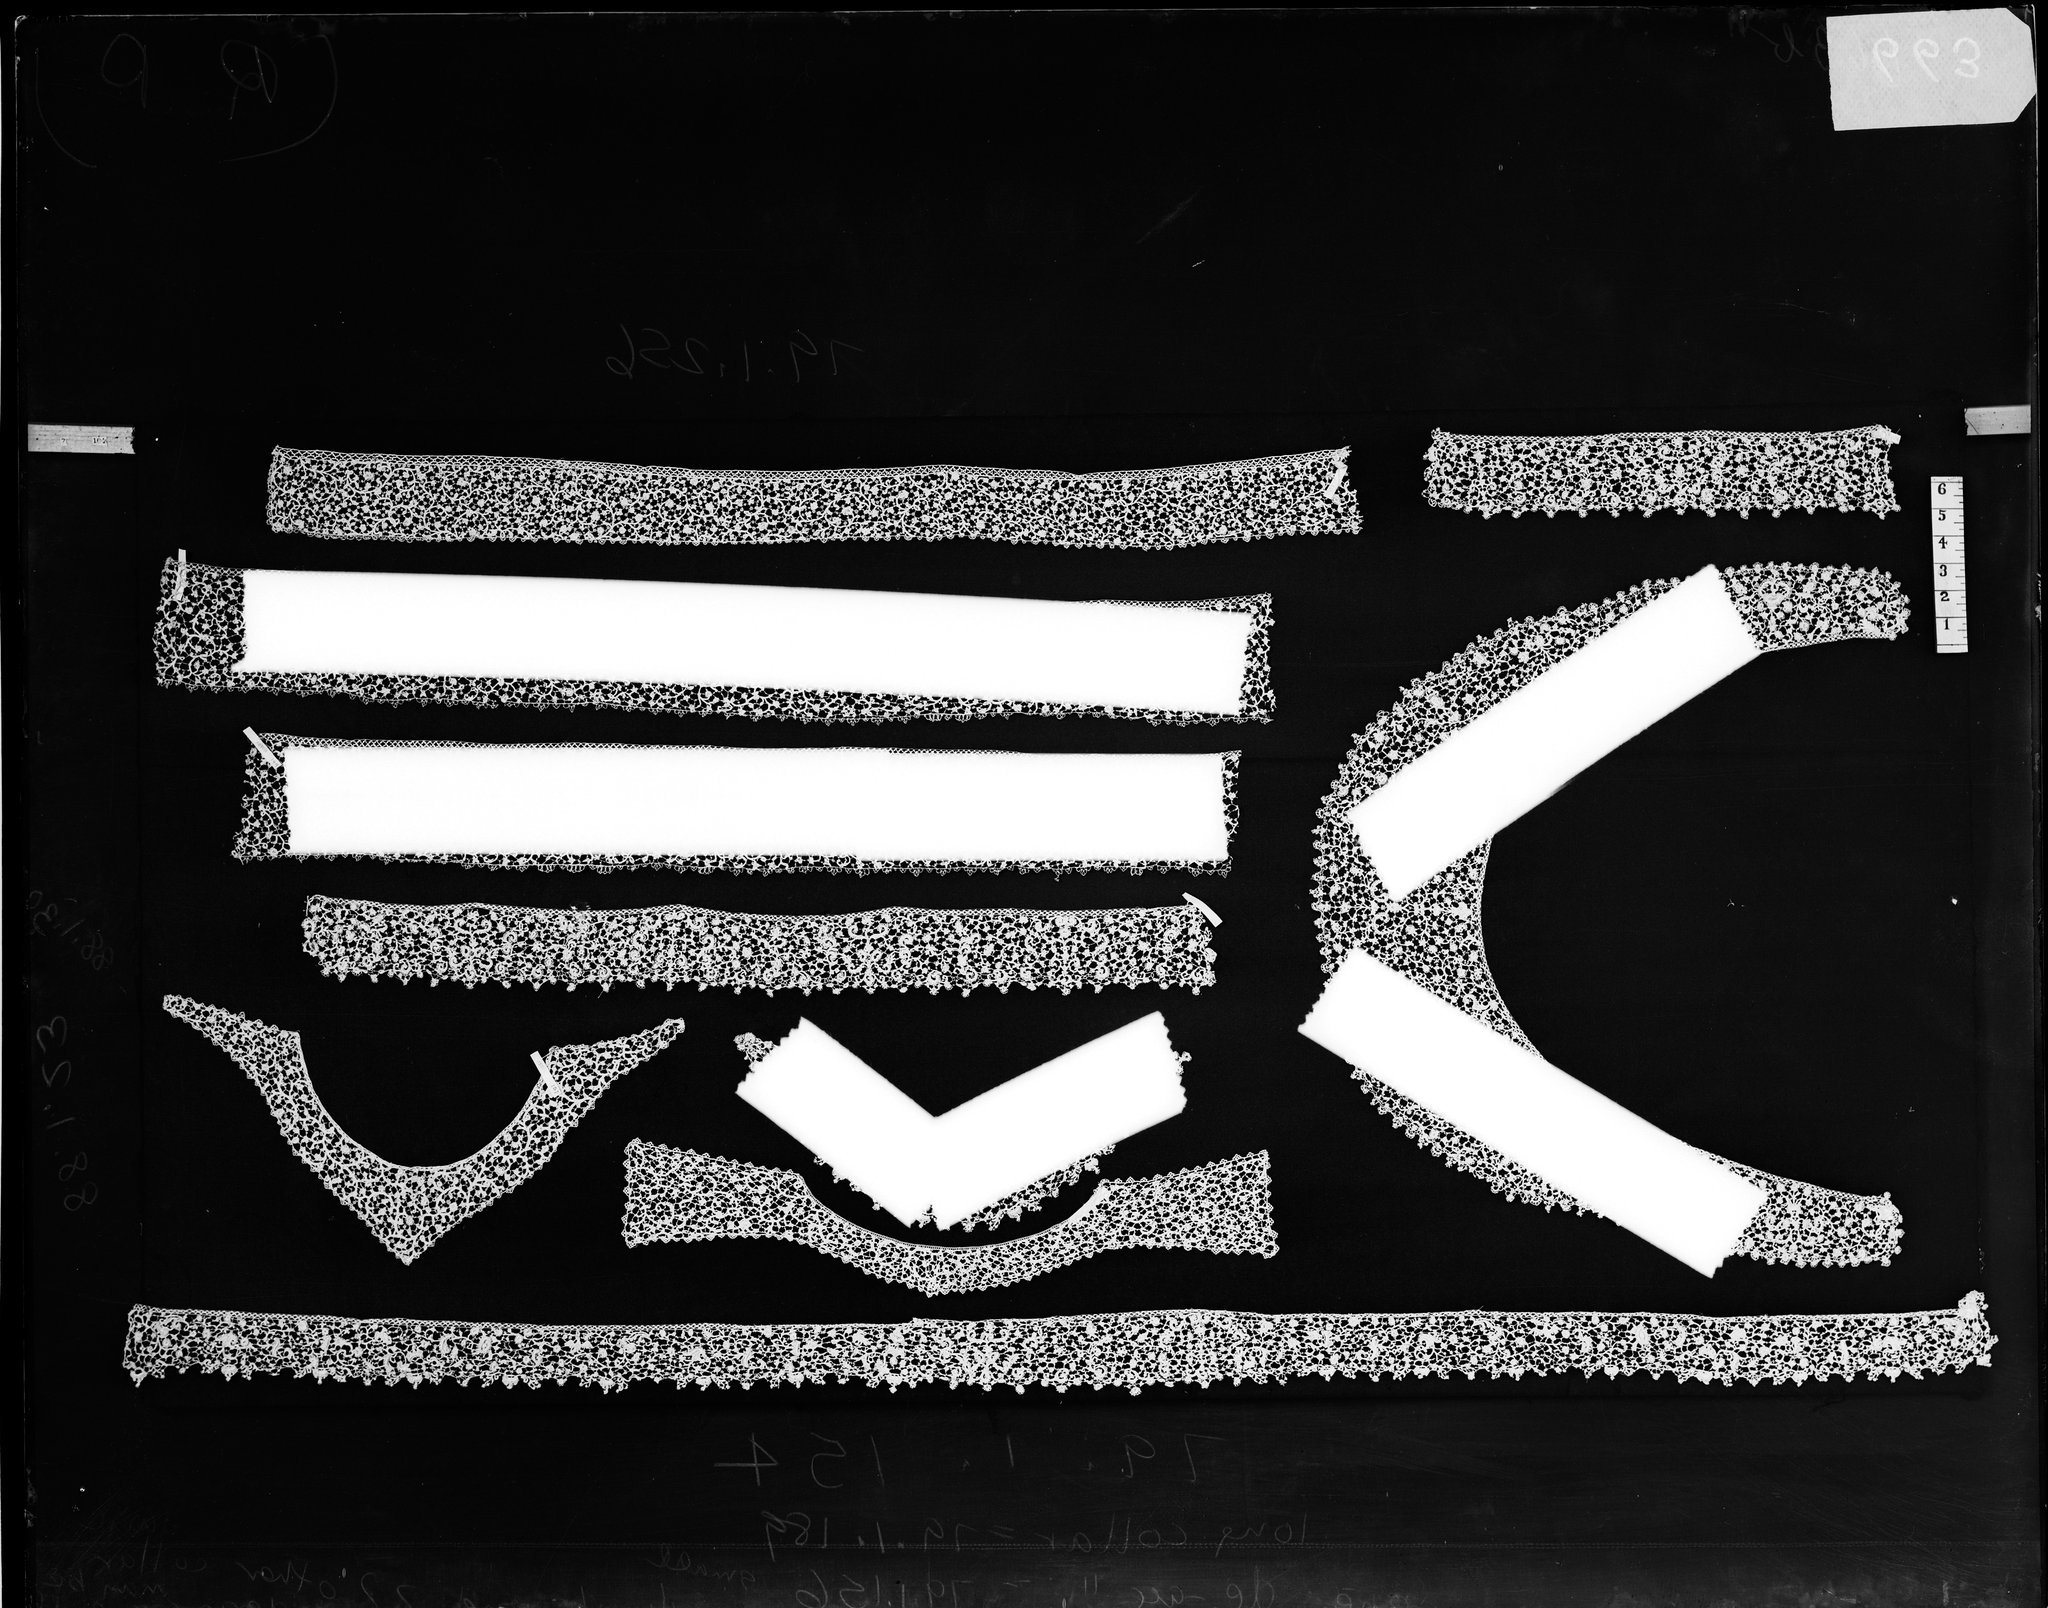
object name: fragment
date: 1701-1733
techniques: lace